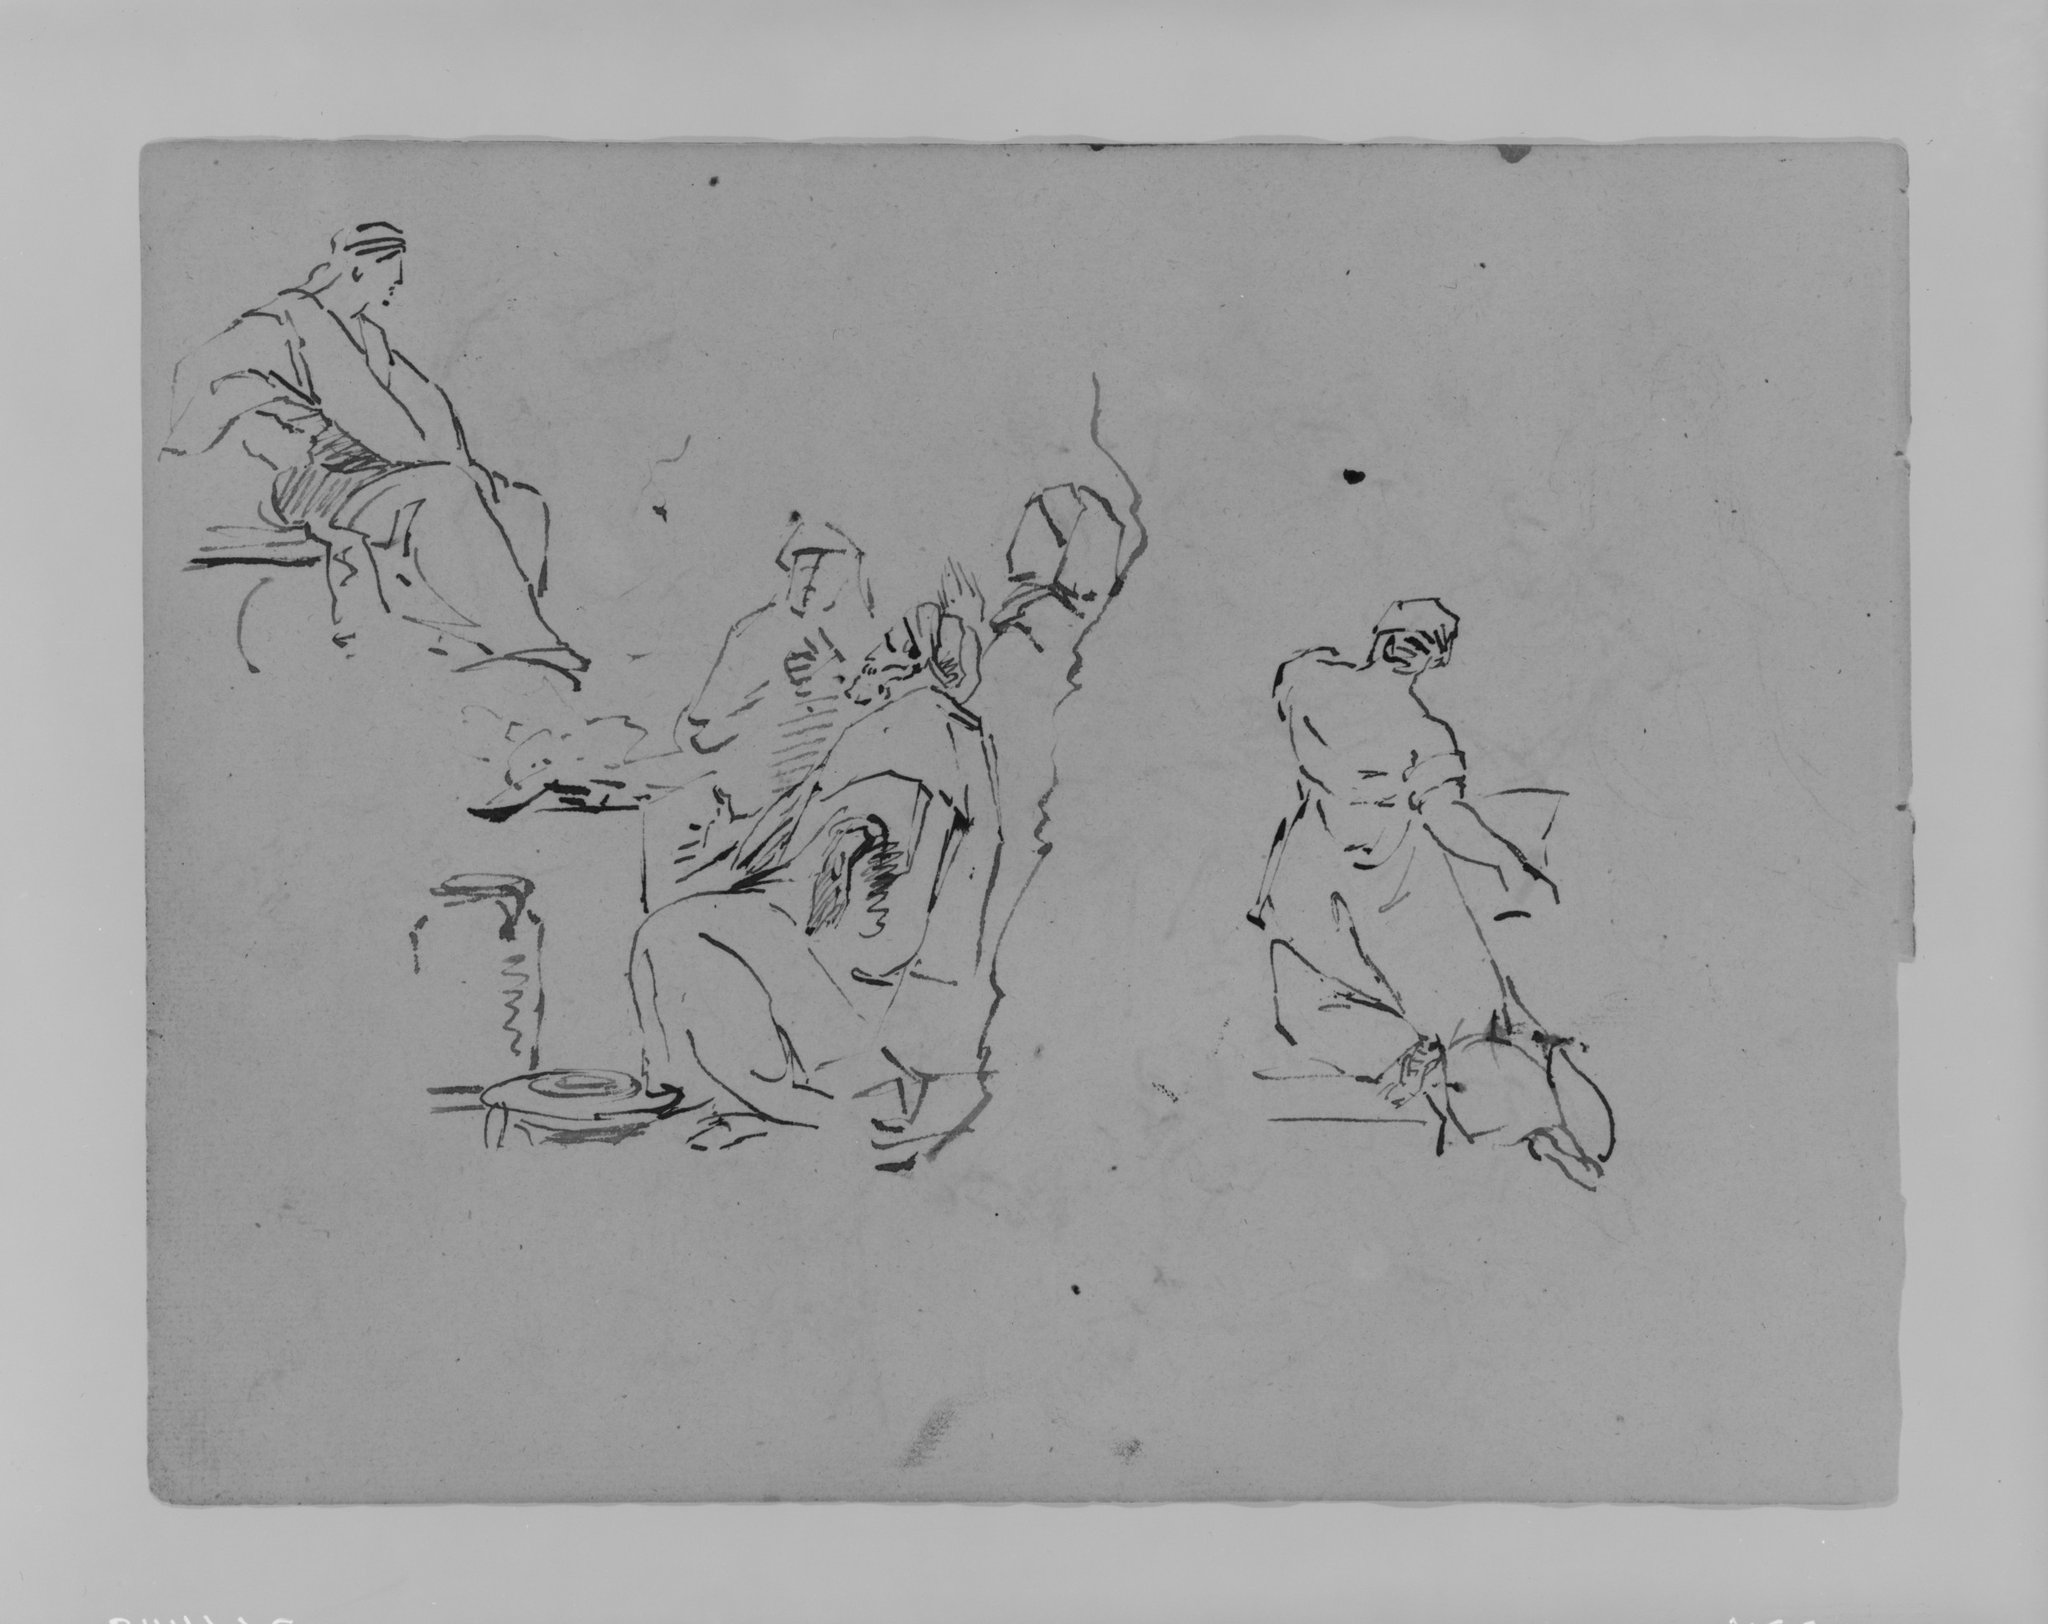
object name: drawing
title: Seated Figure, Three Men in Group, Kneeling Woman from Rear, Kneeling Woman from Rear (from Sketchbook)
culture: american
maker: thomas sully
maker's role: artist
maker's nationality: american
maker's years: 1783-1872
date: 1810-1820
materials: graphite, paper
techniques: wash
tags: men,women